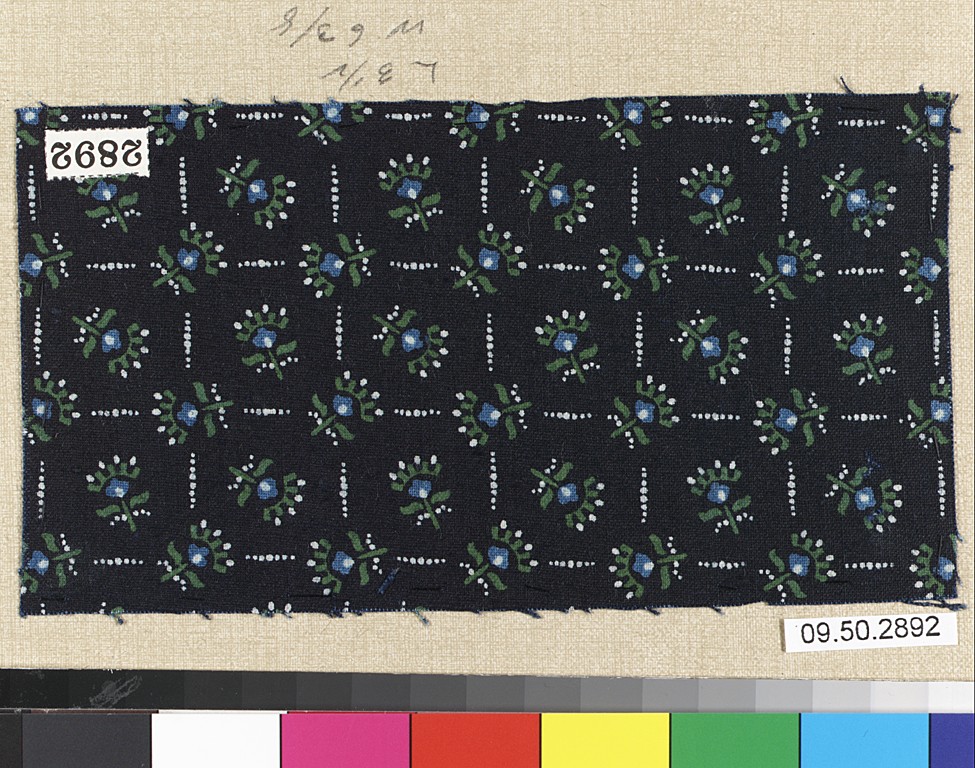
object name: piece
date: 1801-1900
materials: cotton